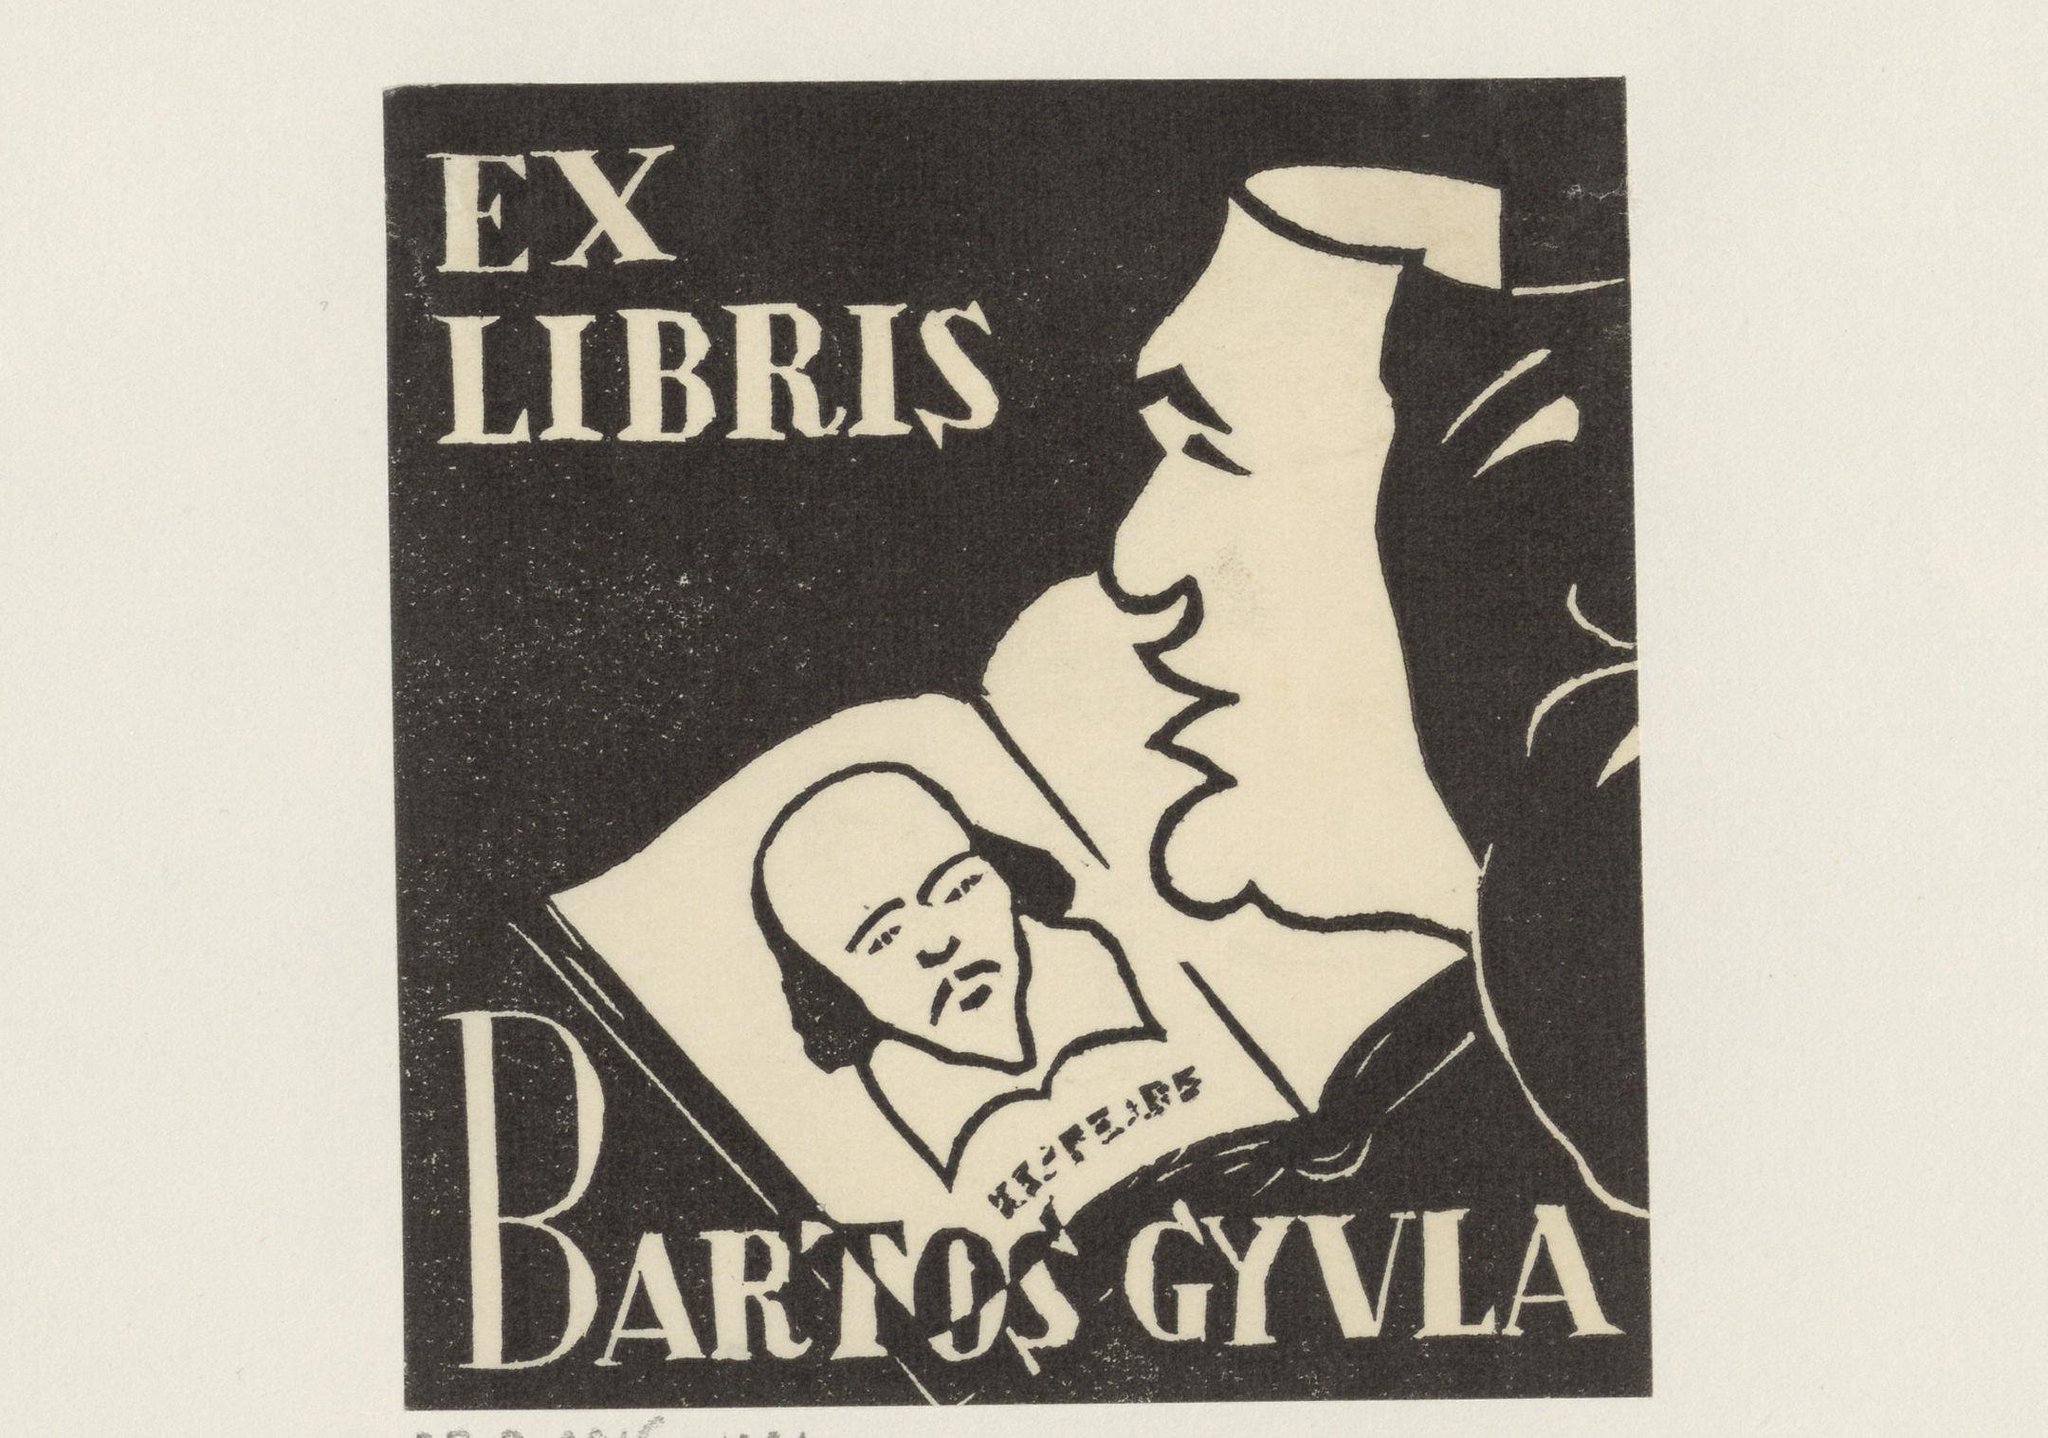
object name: bookplate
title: Ex libris van Bartos Gyula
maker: lászló bartos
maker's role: print maker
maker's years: 1902-1943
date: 1934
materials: paper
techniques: linocut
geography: hungary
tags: william shakespeare, theatre, theatrical performance